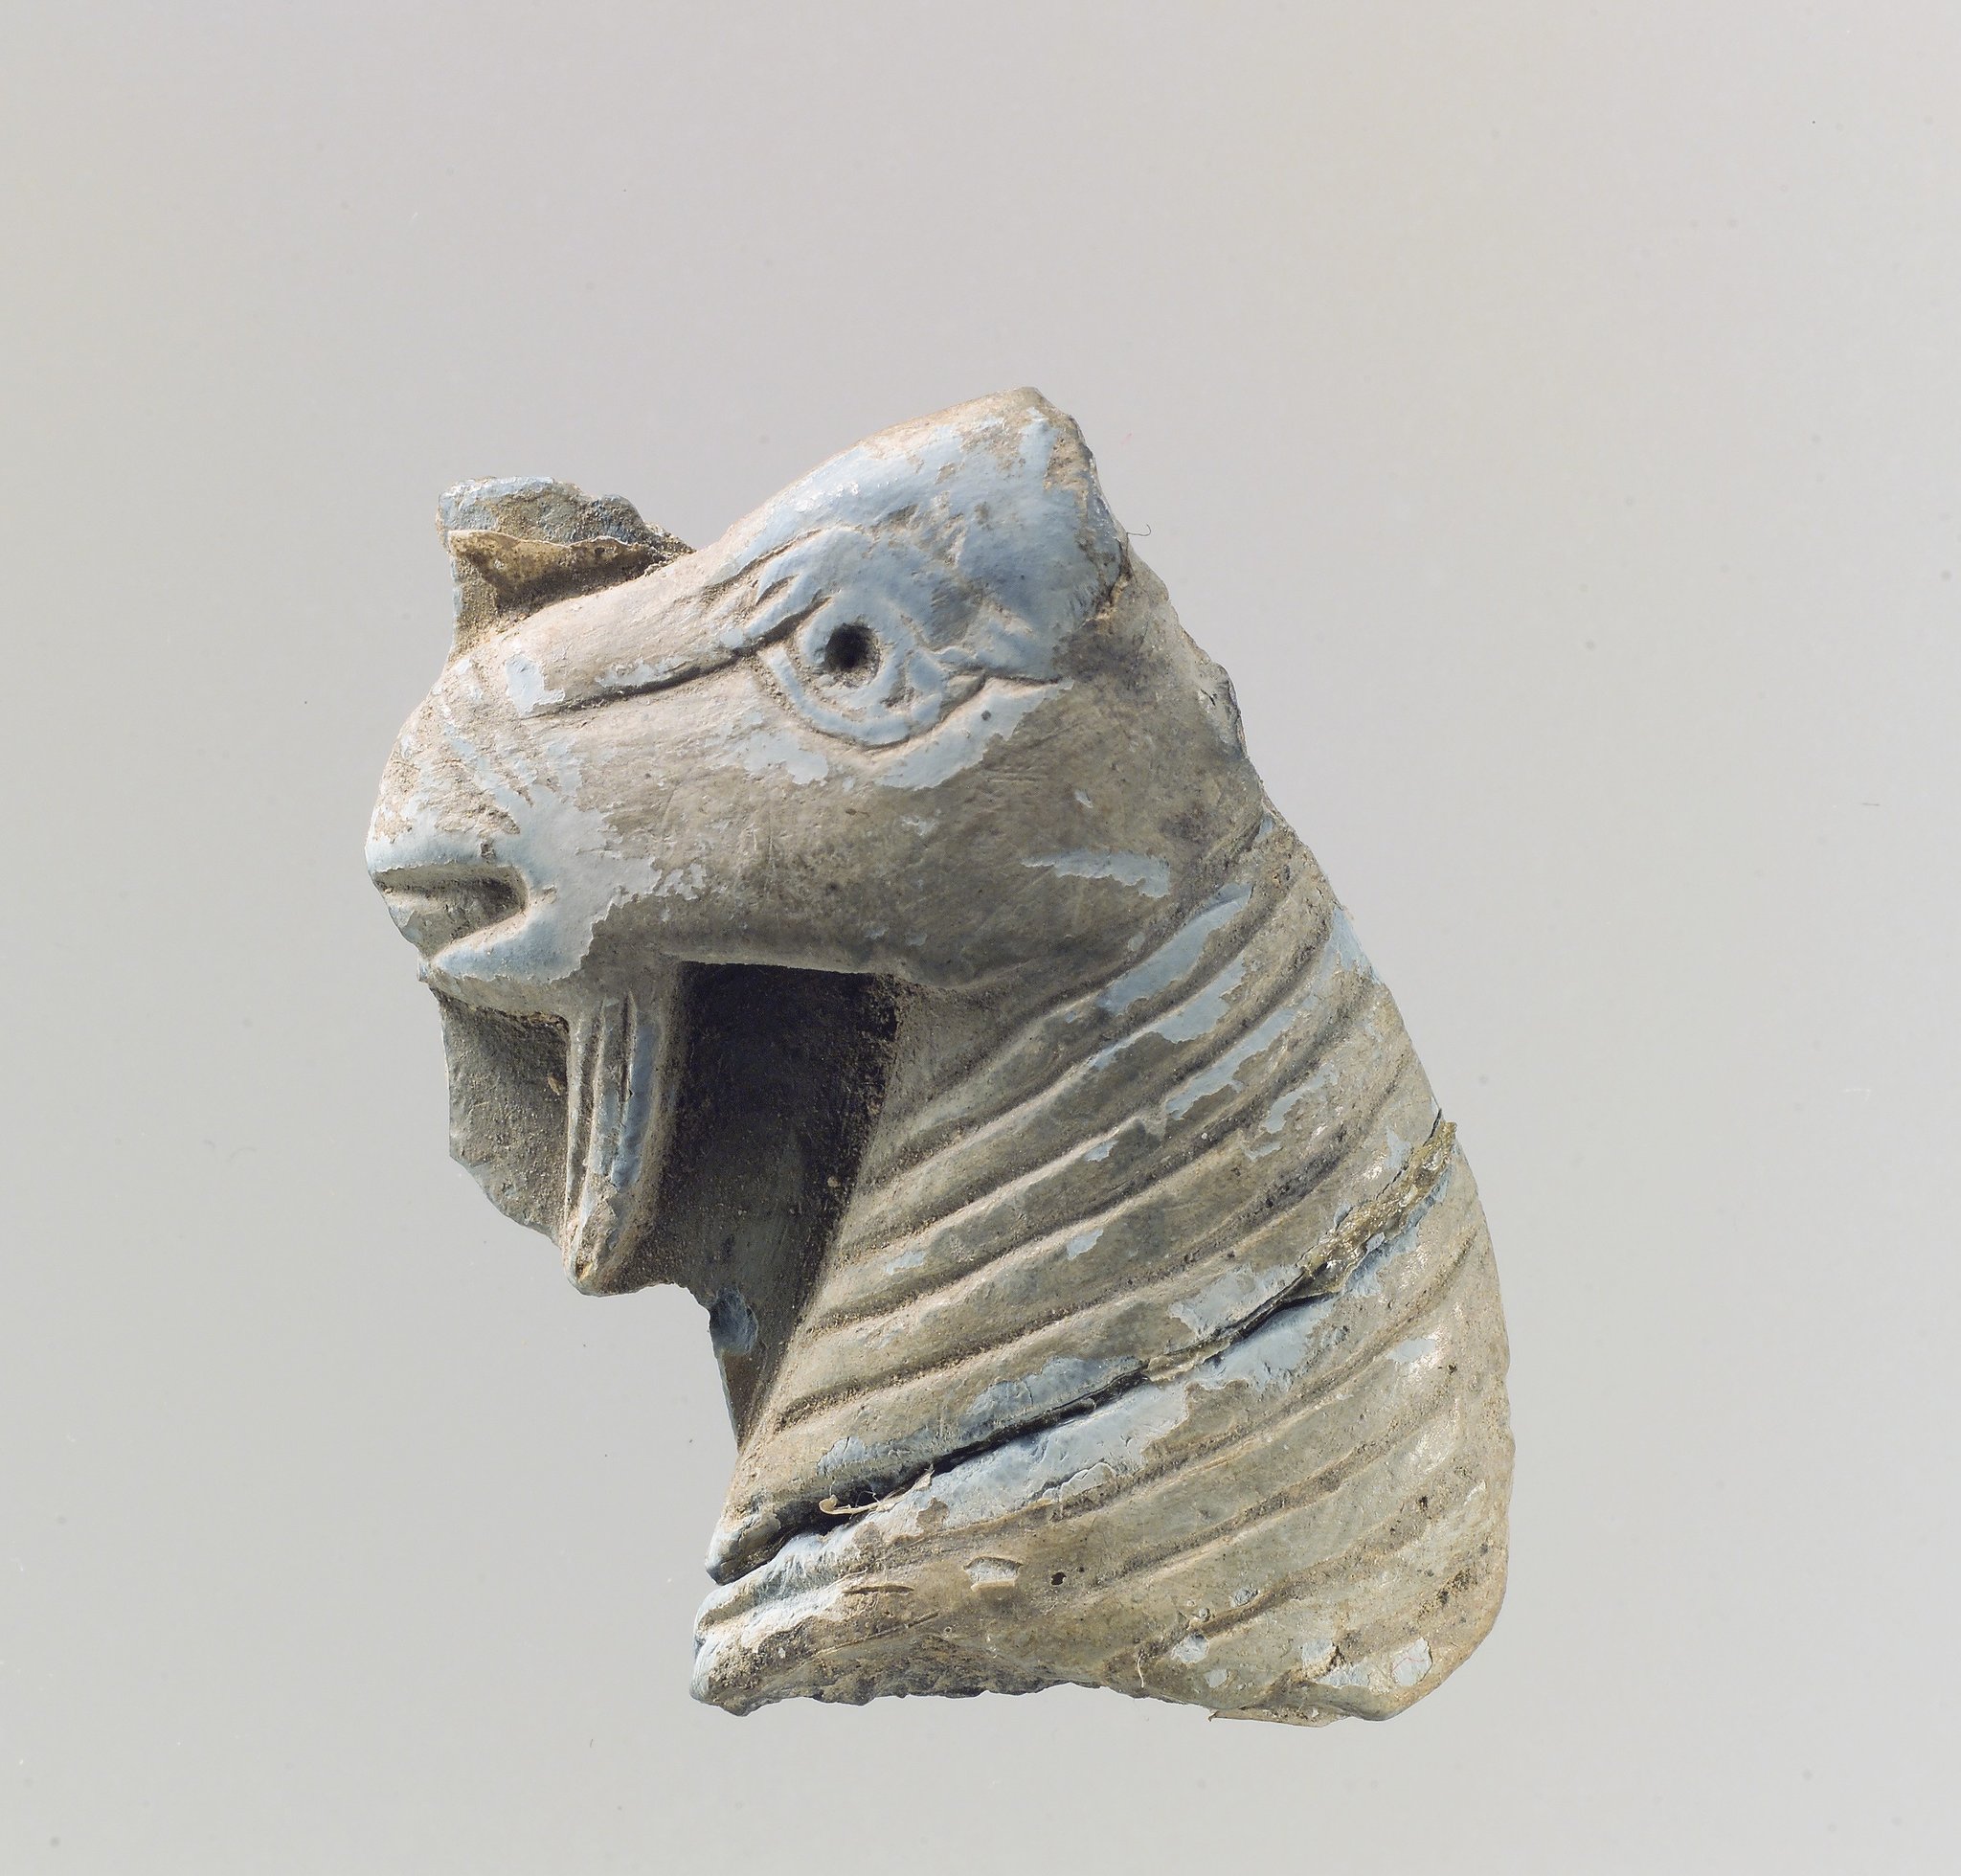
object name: relief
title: Plaque fragment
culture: assyrian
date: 900-701 BCE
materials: ivory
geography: mesopotamia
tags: animals